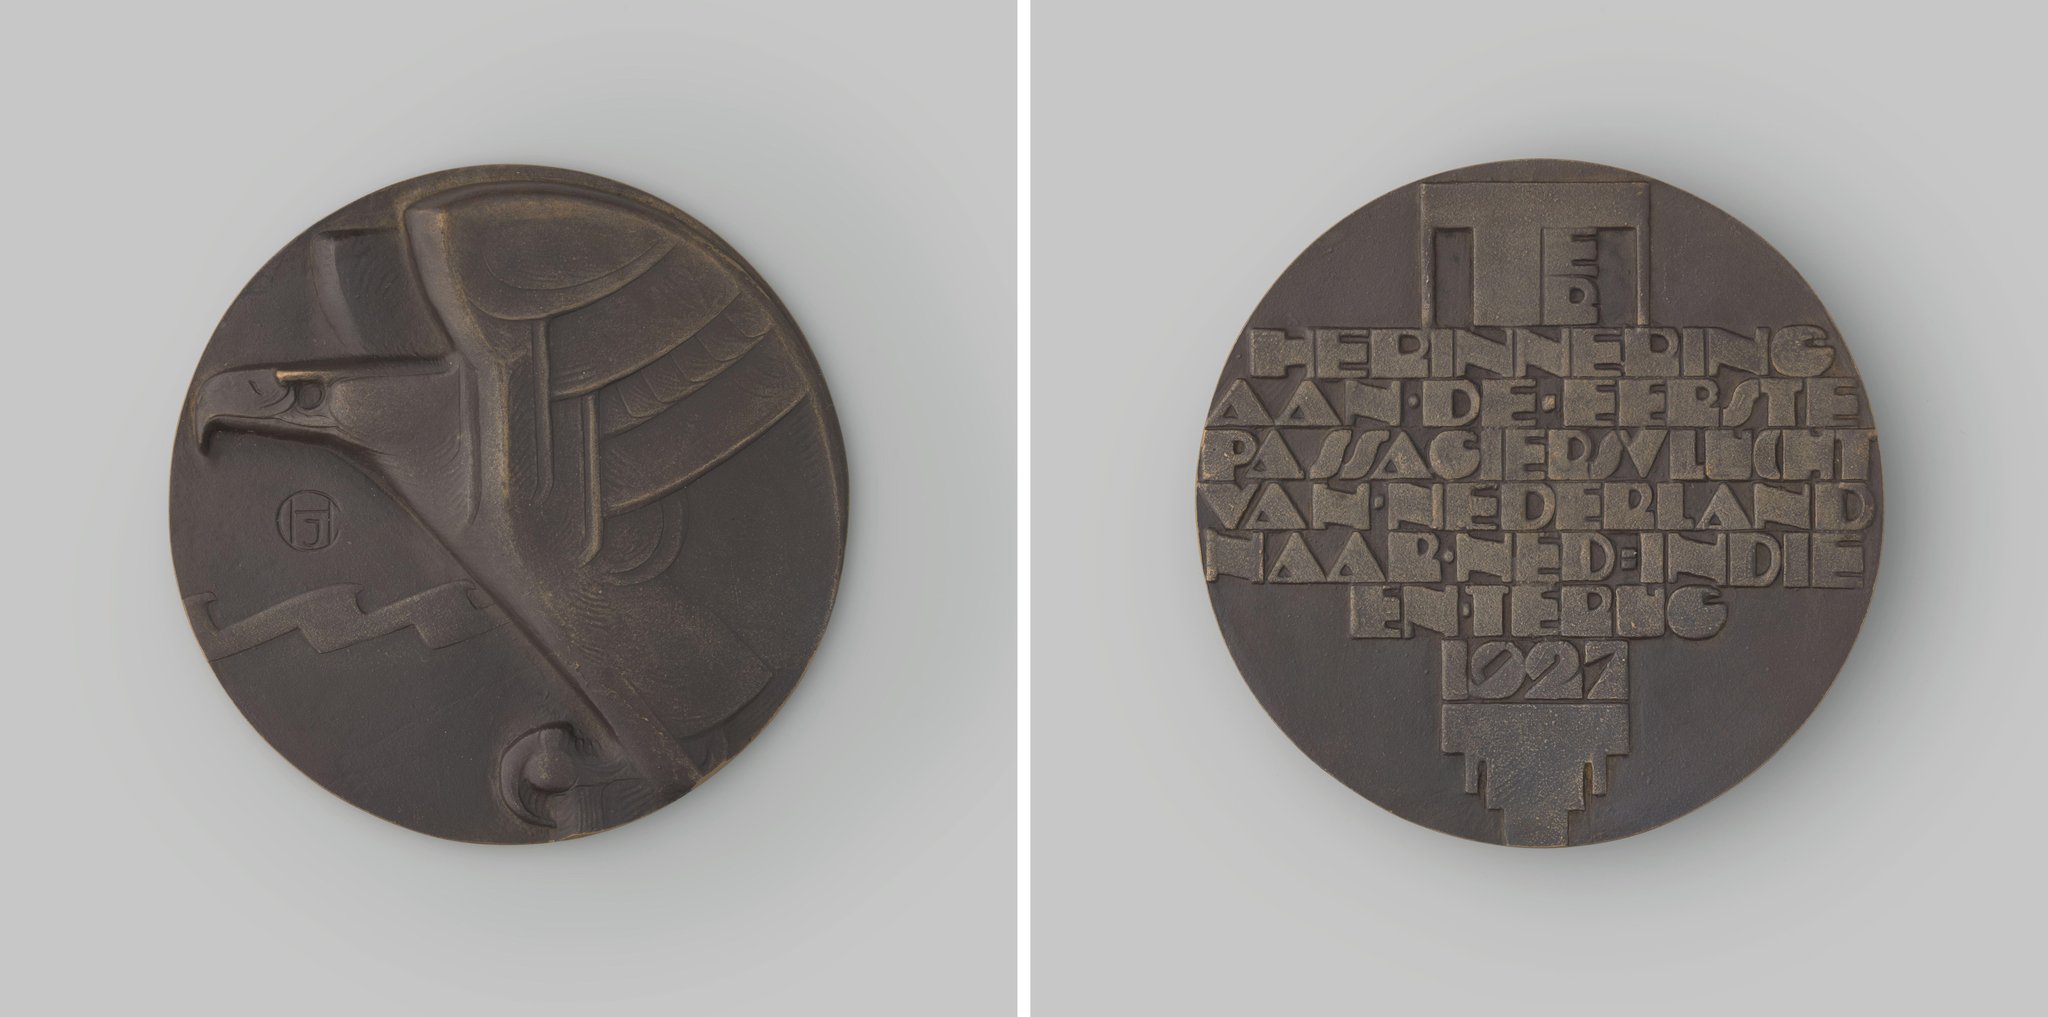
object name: medal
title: First Passenger Flight from the Netherlands to the Dutch East Indies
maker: chris van der hoef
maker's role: ceramicist, draughtsman, sculptor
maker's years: 1875-1933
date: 1927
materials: bronze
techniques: casting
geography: netherlands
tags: dutch east indies, the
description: The Rijksmuseum’s medal collection, boasting some 12,500 objects, is almost a century and a half old. The museum continues to expand its collection with special medals, which are either purchased, donated, or given on loan. On display here are a number of the most extraordinary acquisitions of recent years. These are honorary and commemorative medals. Several are unique and came from the descendants of the individuals who once received them.